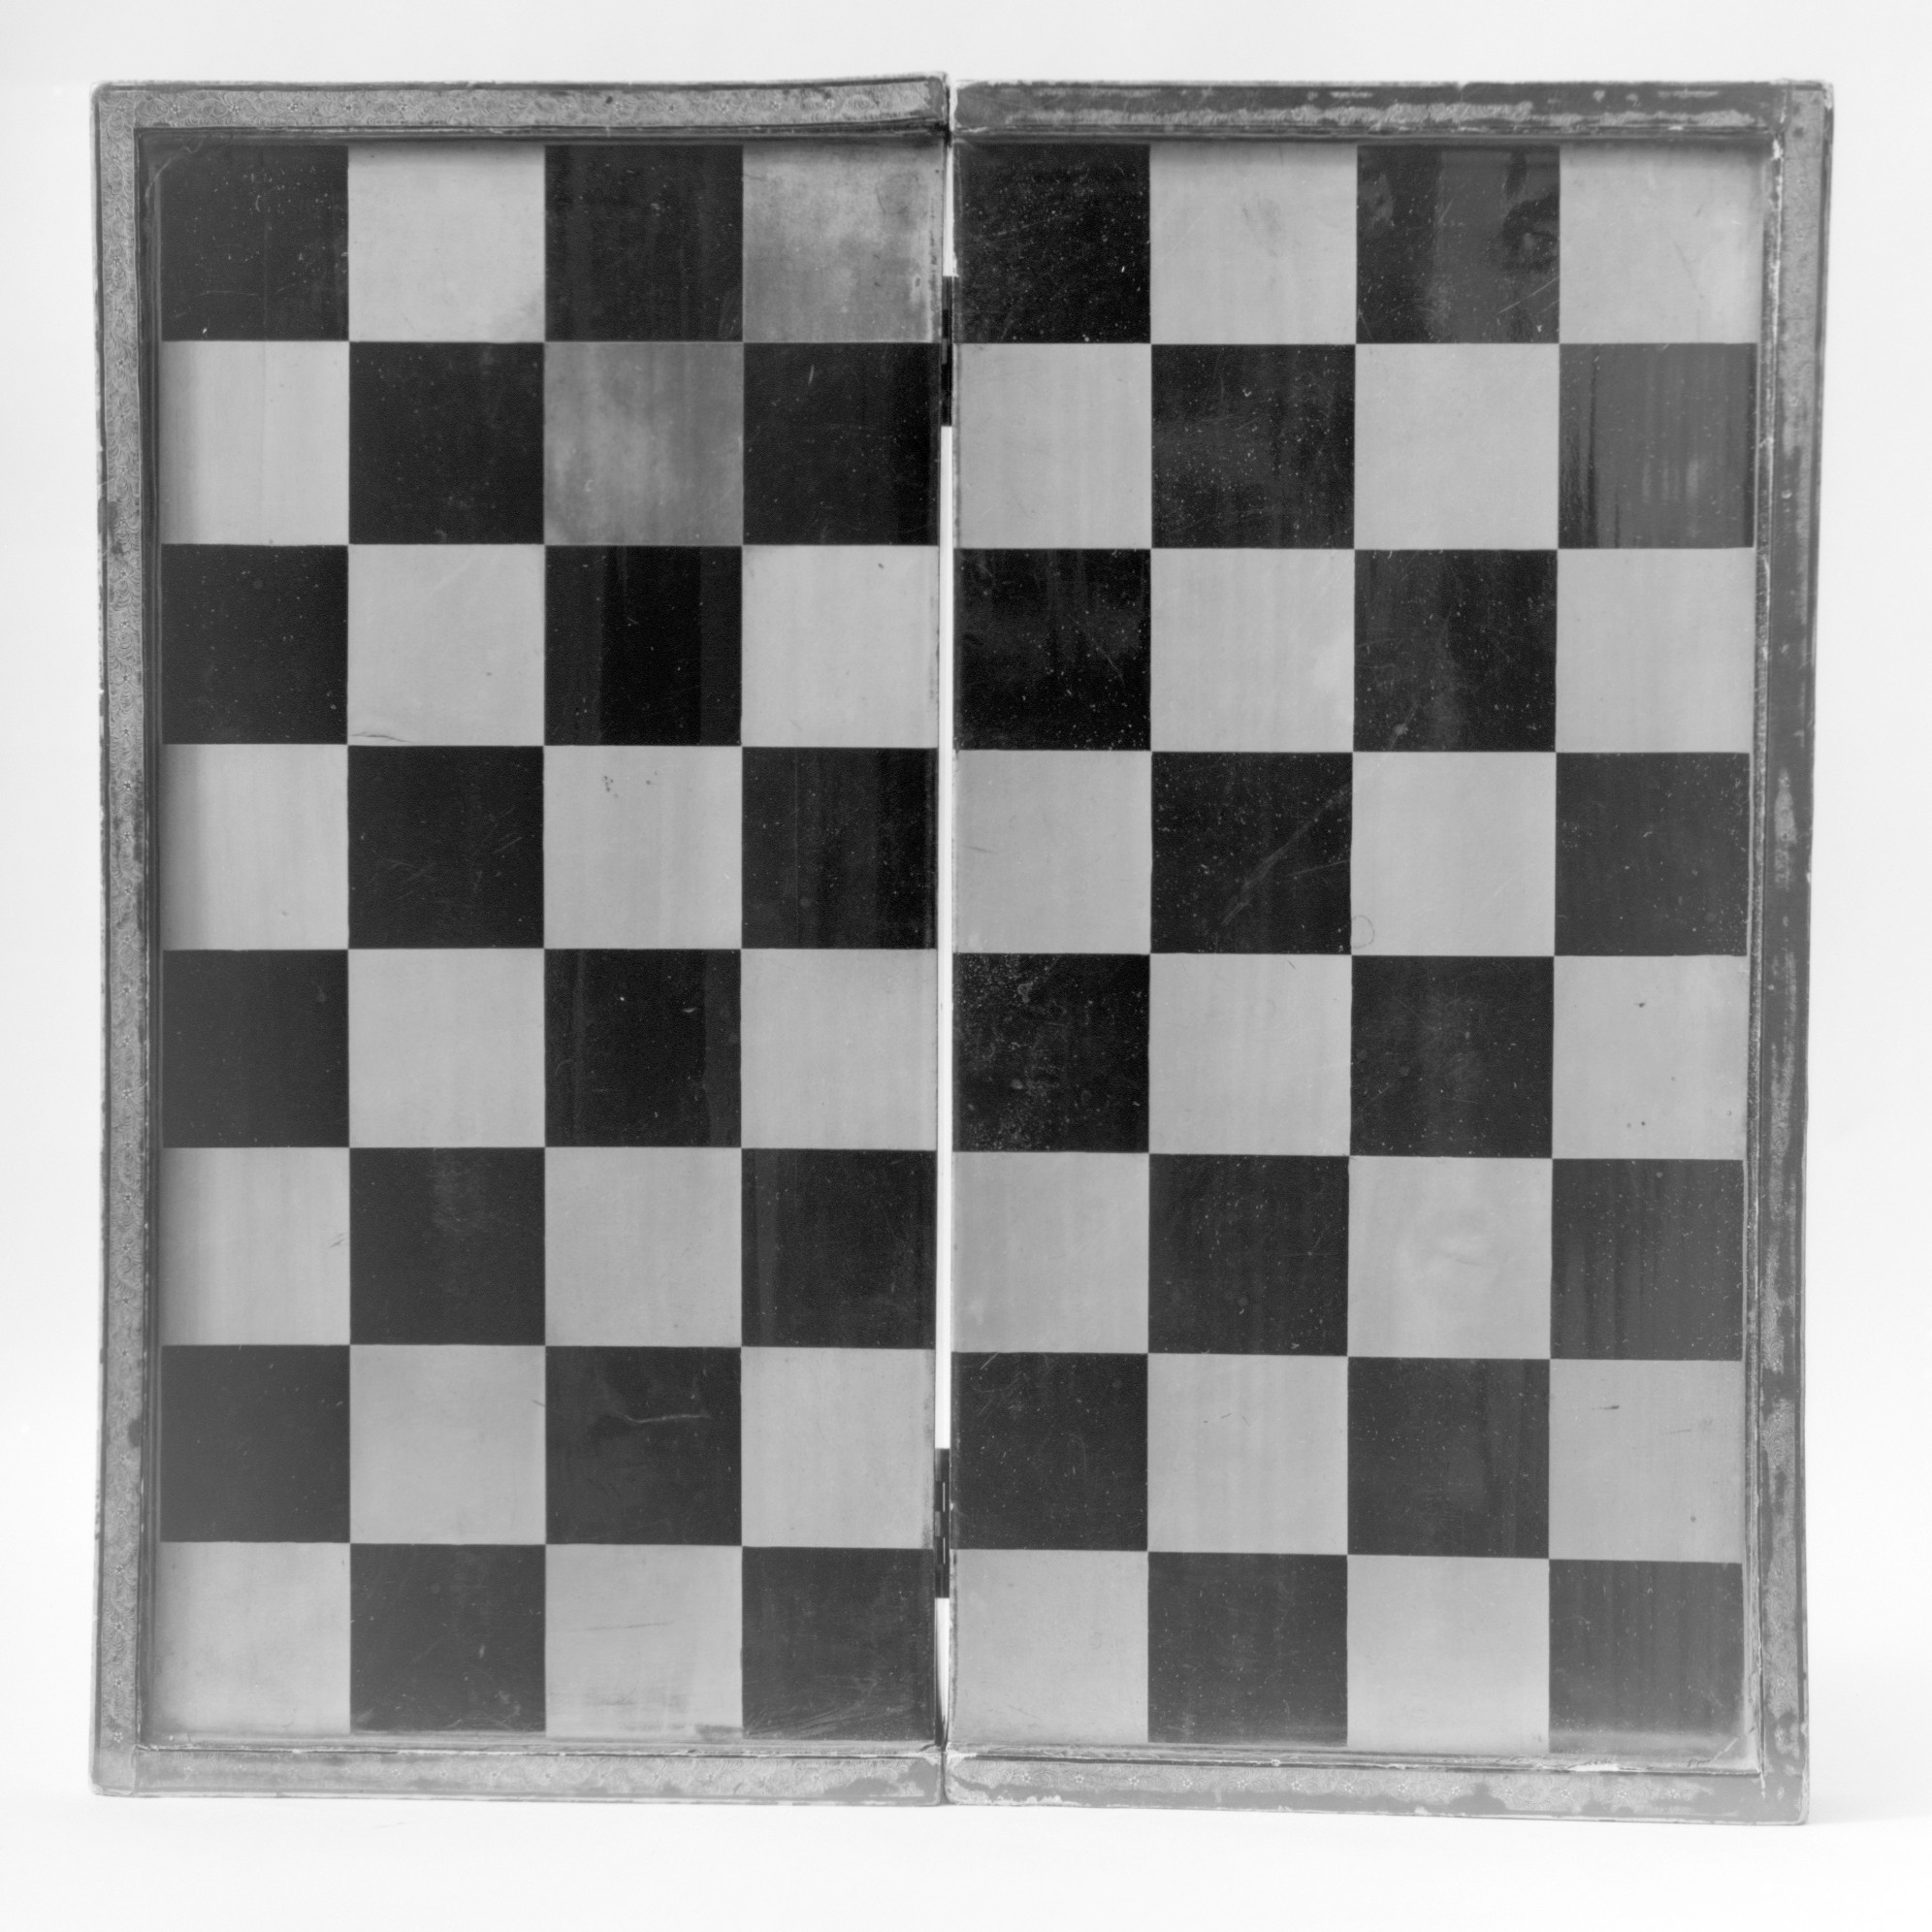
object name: chessboard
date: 1801-1900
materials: wood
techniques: lacquer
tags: chess,games